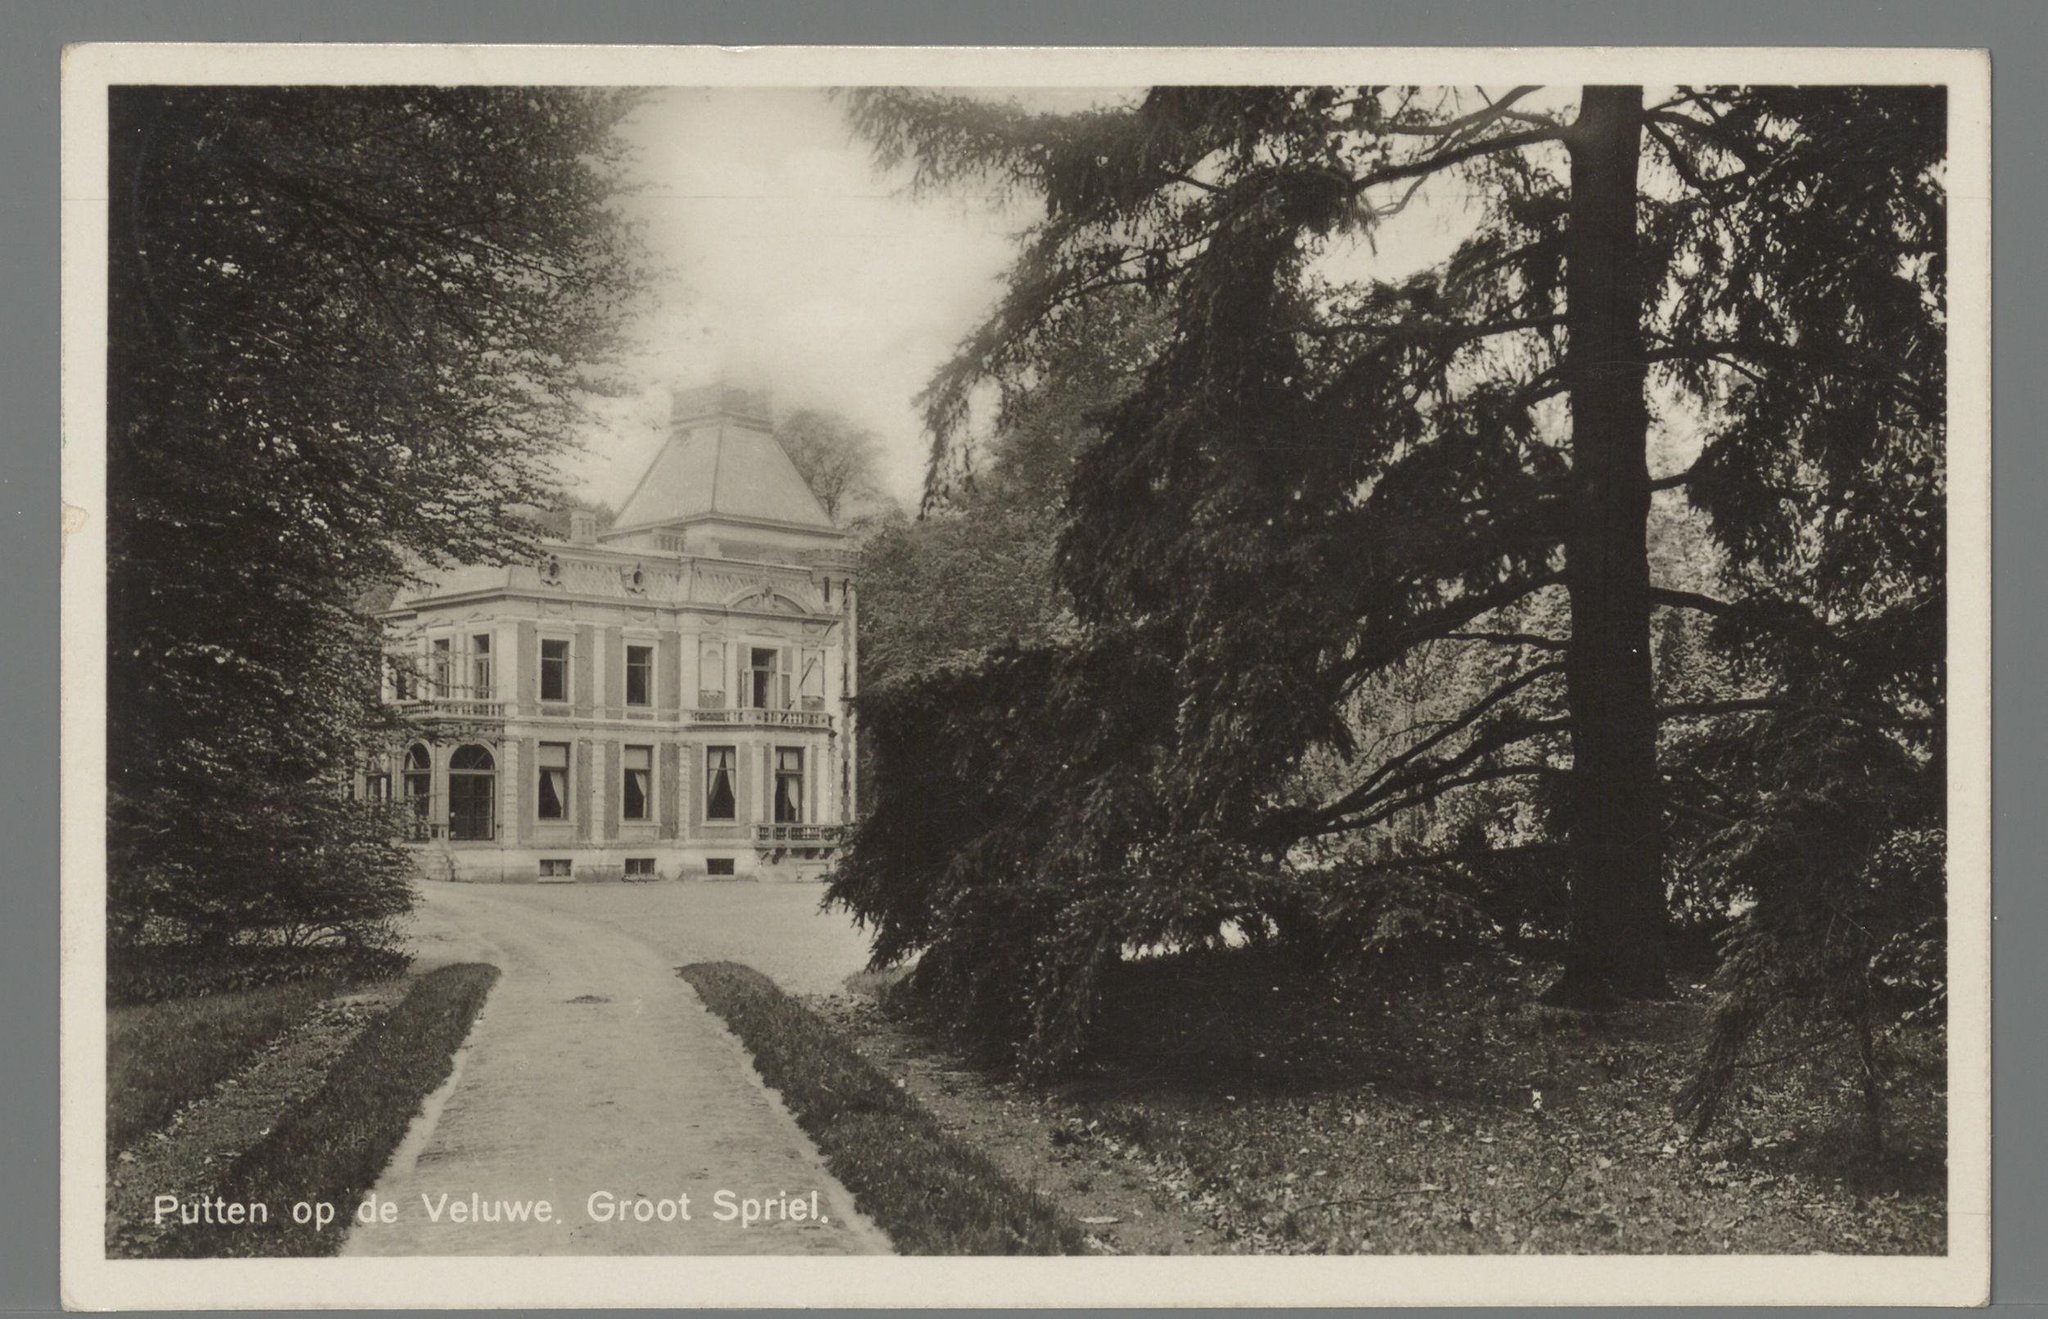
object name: photograph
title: Putten op de Veluwe. Groot Spriel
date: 1929-1931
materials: paper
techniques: gelatin silver print, writing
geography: putten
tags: villa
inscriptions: postage stamp